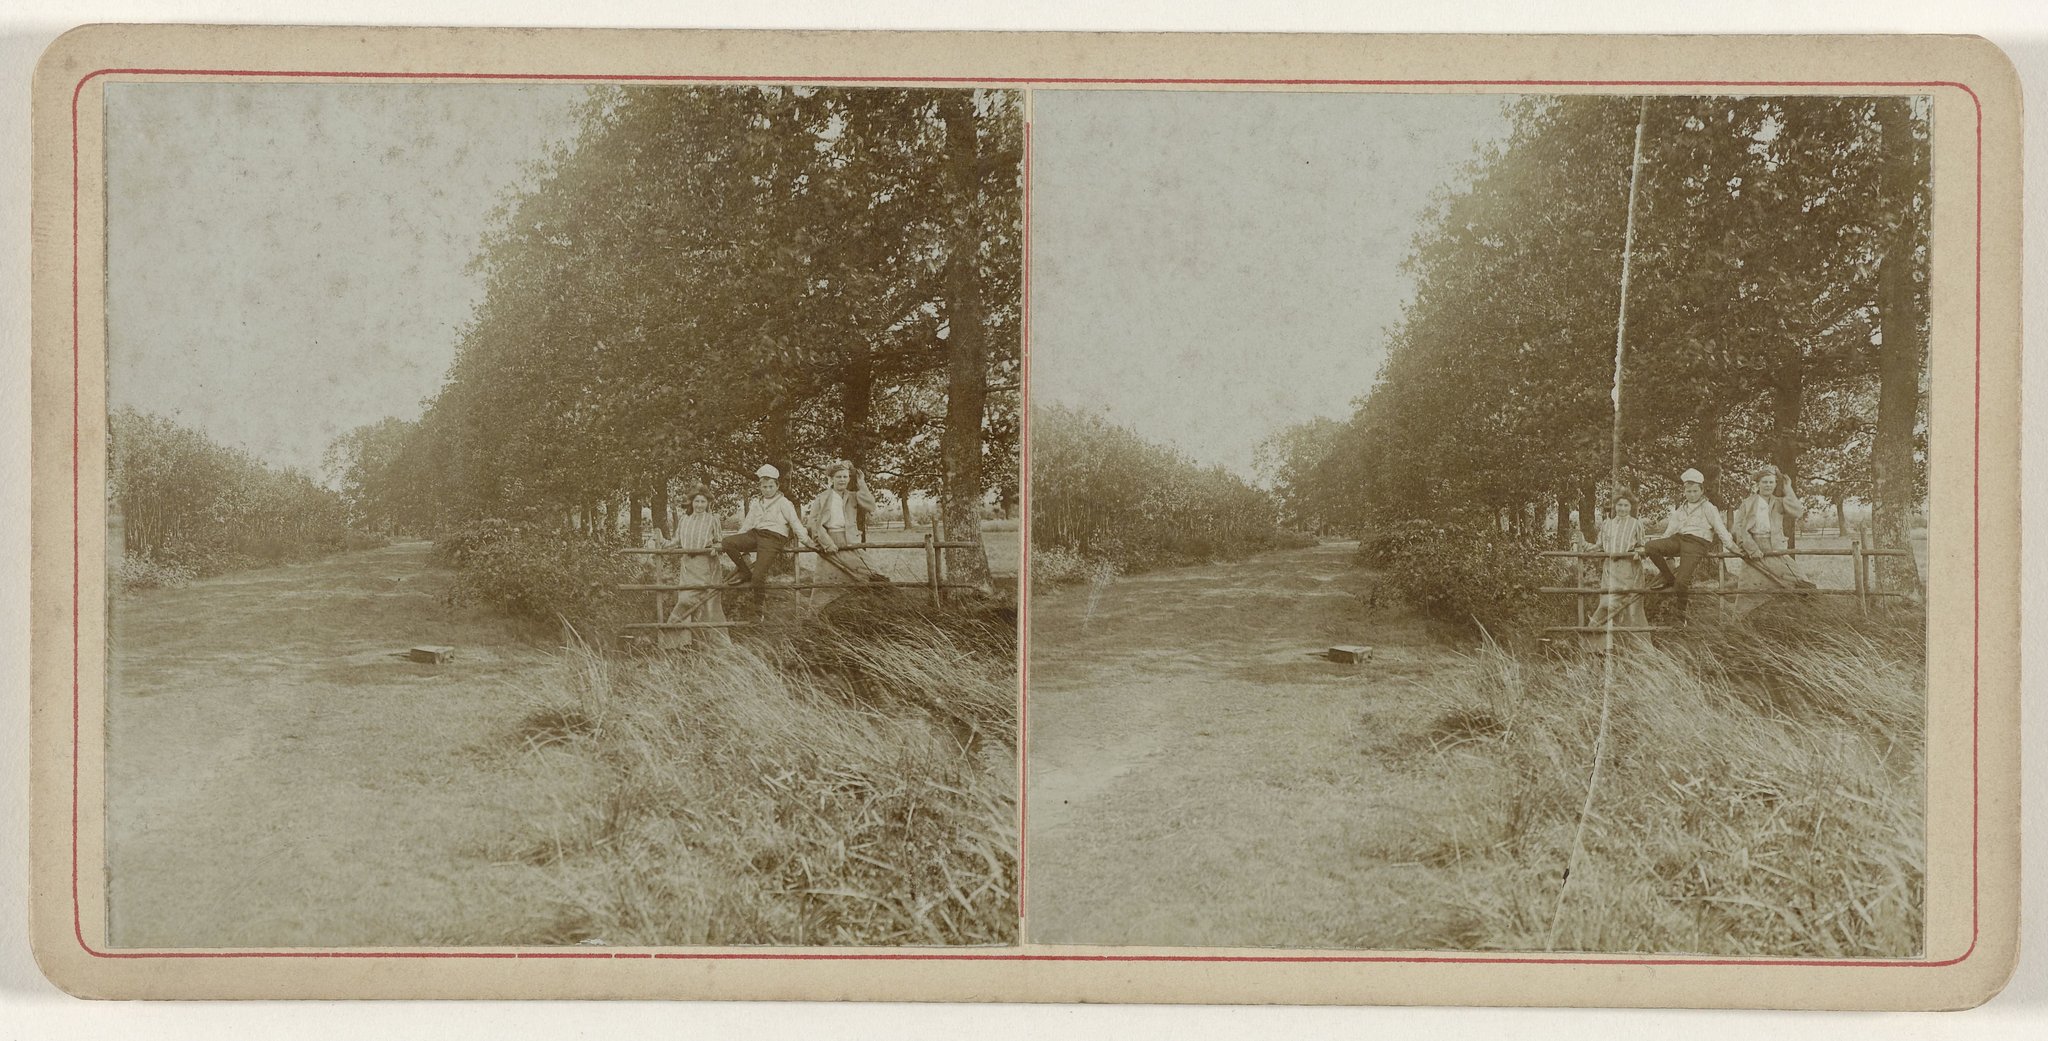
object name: stereograph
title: Laantje bij Ter Horst. Aug 1904.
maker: geldolph adriaan kessler (dolph)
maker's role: fotograaf, industrieel, voetballer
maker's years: 1884-1945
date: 1904-1908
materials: paper, photographic support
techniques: collodion silver print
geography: potsdam